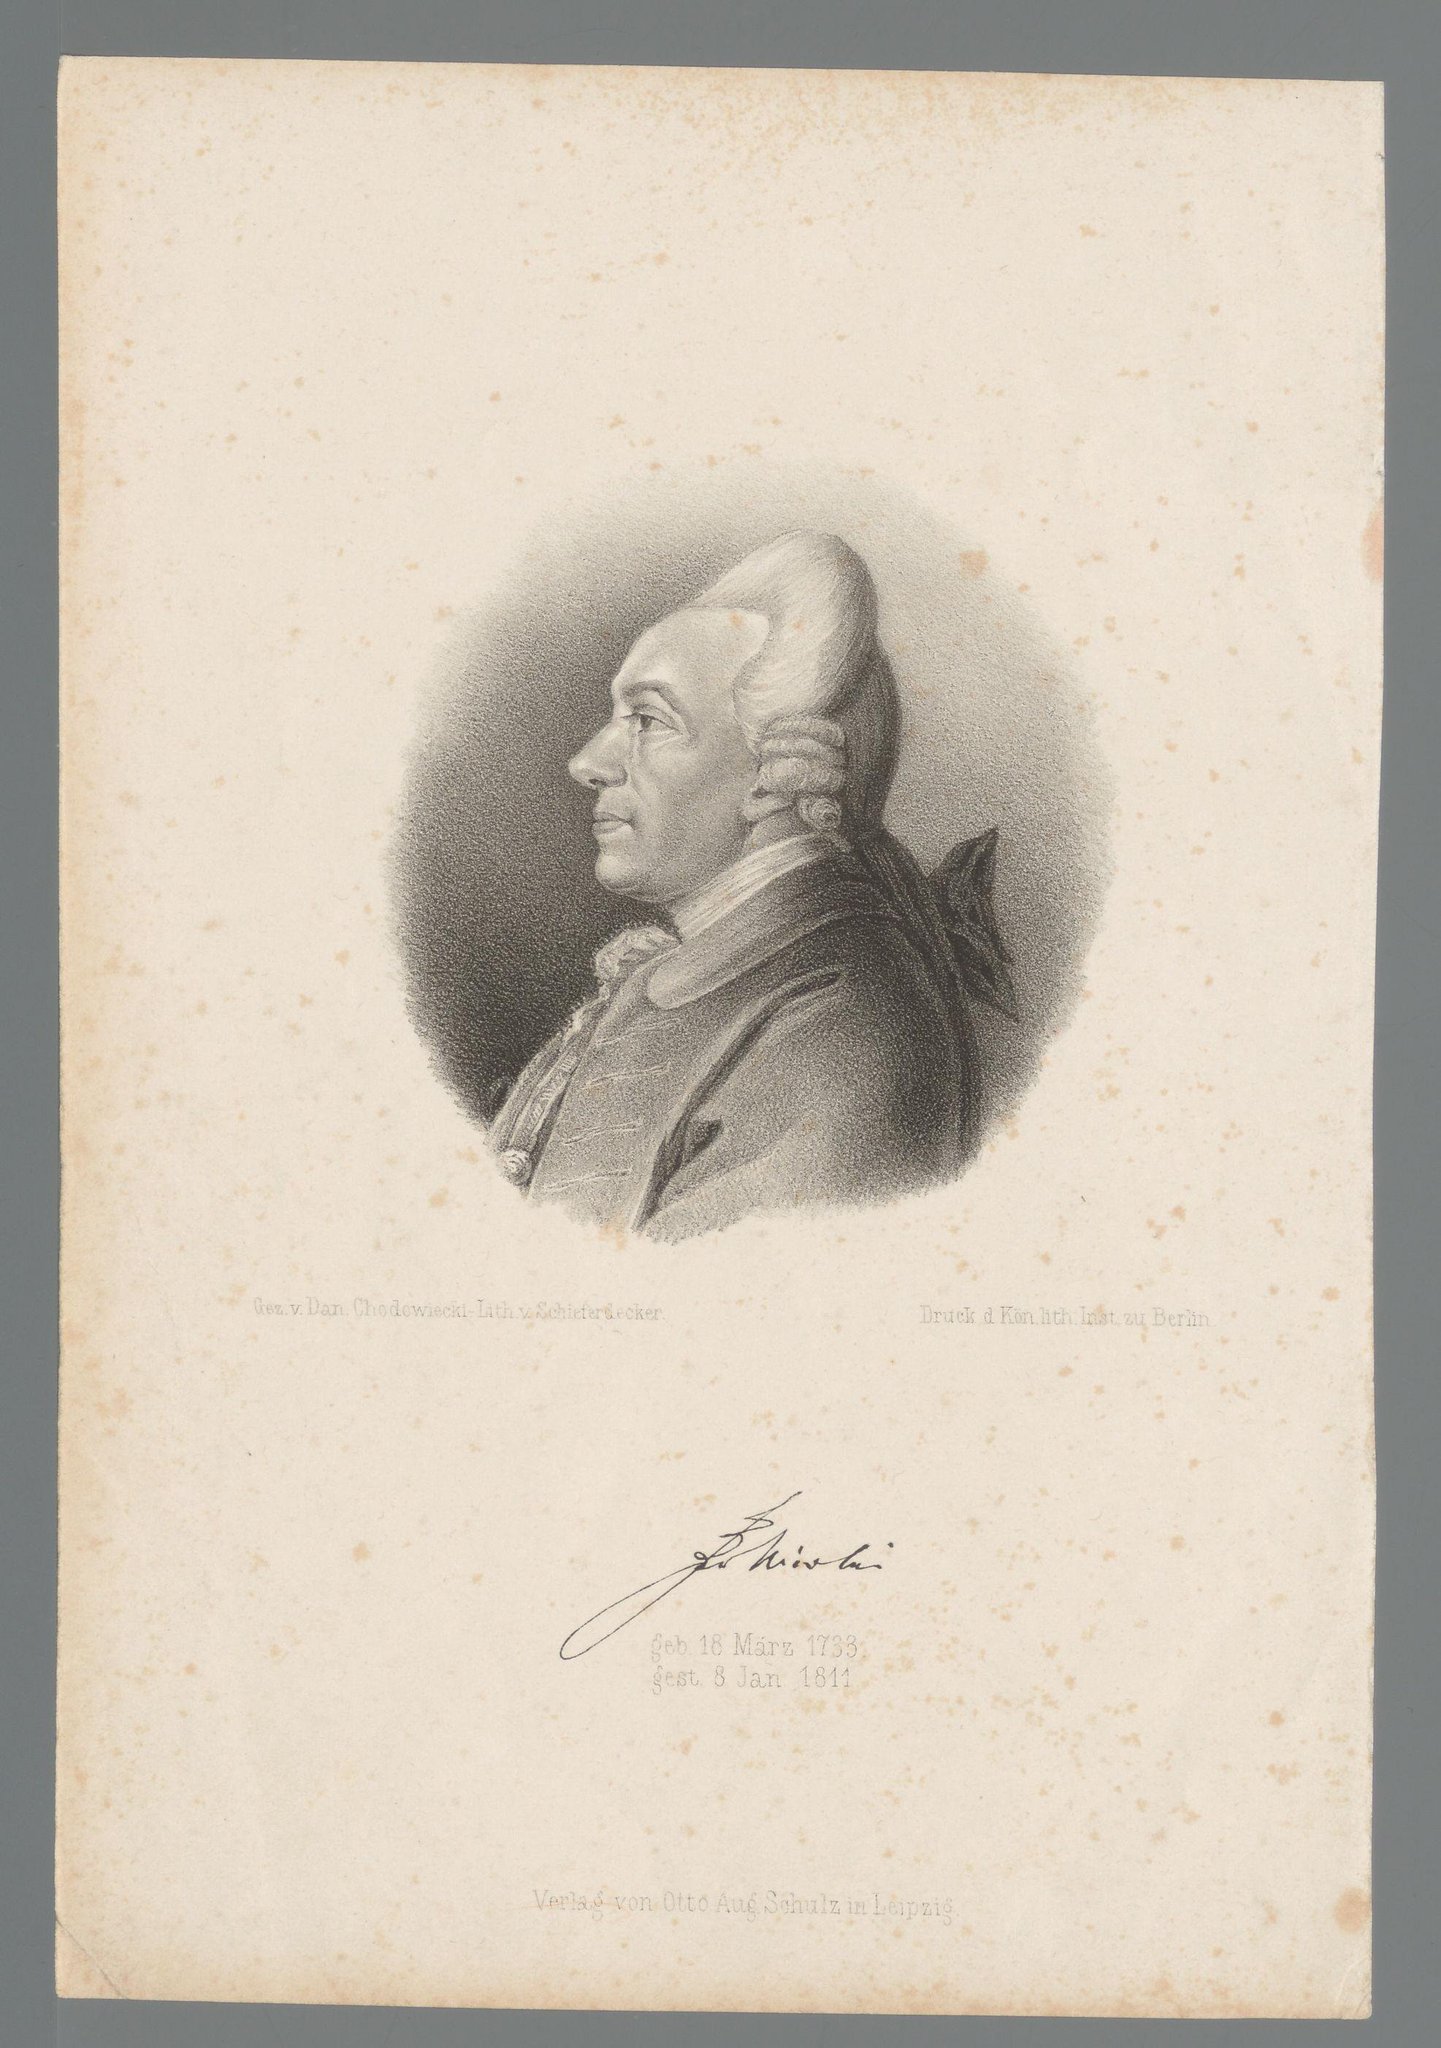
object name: print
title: Portret van Christoph Friedrich Nicolai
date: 1833-1878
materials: paper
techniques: lithograph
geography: leipzig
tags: berlin, historical persons, publishing, publisher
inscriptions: collector's mark: Lugt 2228